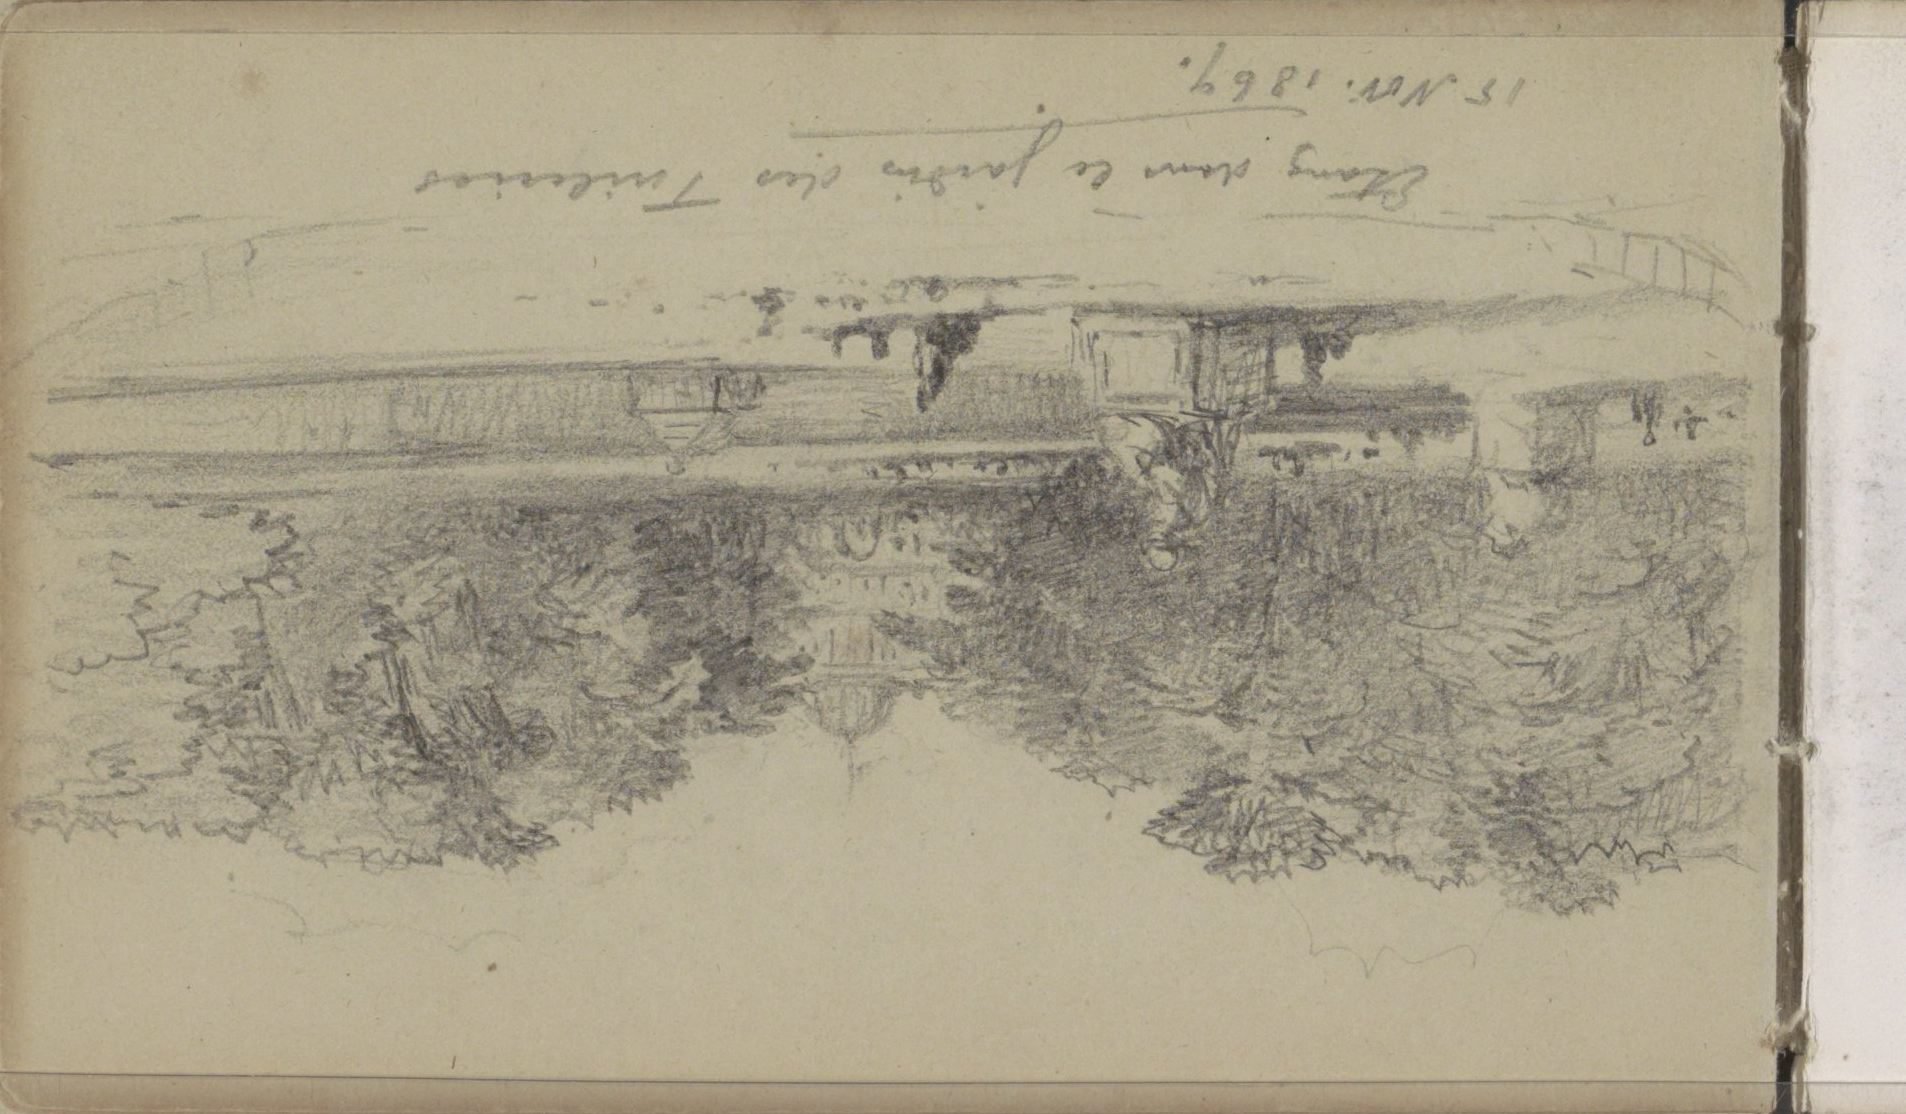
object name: sketchbook leaf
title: Vijver in de Jardin des Tuileries te Parijs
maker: maria vos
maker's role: draughtsman, painter, print maker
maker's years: 1824-1906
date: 1811-1867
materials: paper, pencil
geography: paris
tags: park, garden pond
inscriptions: date and inscription: ‘Etang dans le jardin des Tuileries/ 15 Nov. 1867.’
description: Blad 34 verso uit een schetsboek met 40 bladen.